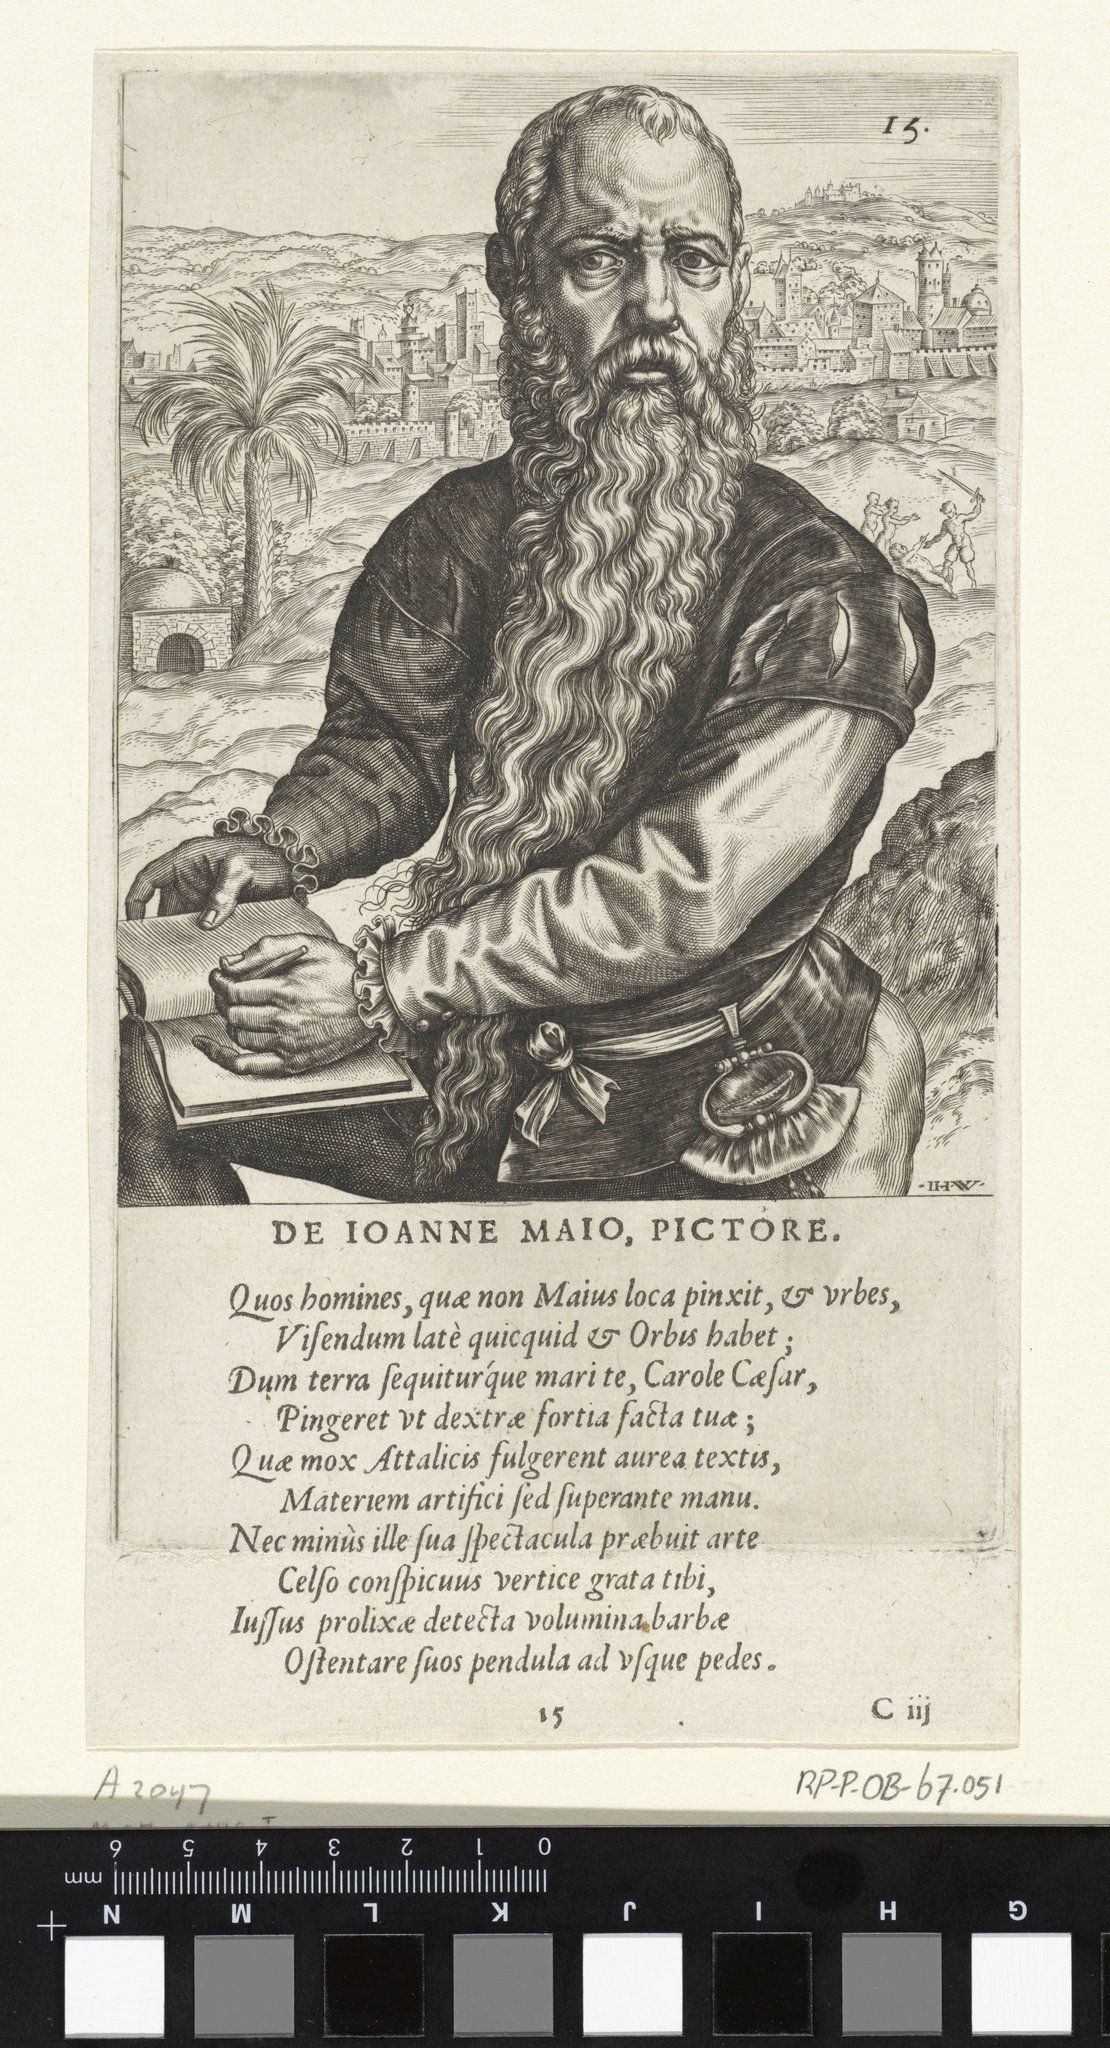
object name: print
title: Portrait of Jan Cornelisz Vermeyen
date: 1572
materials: paper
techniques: engraving, letterpress printing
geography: antwerp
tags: painter, print maker, draughtsman, jan cornelisz vermeyen, city-view, and landscape with man-made constructions, portrait, self-portrait of painter, killing ~ aggressive relationships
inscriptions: collector's mark: Lugt 2228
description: Less than fifteen years after his death, Vermeyen was included in a series of portrait prints of the most famous Netherlandish artists. While he had made his reputation with his art, he was also known for his striking appearance. According to a contemporary, Vermeyen’s beard was at least a metre long. The background in this print refers to Emperor Charles v’s campaign to conquer Tunis, in which Vermeyen took part as an artist.